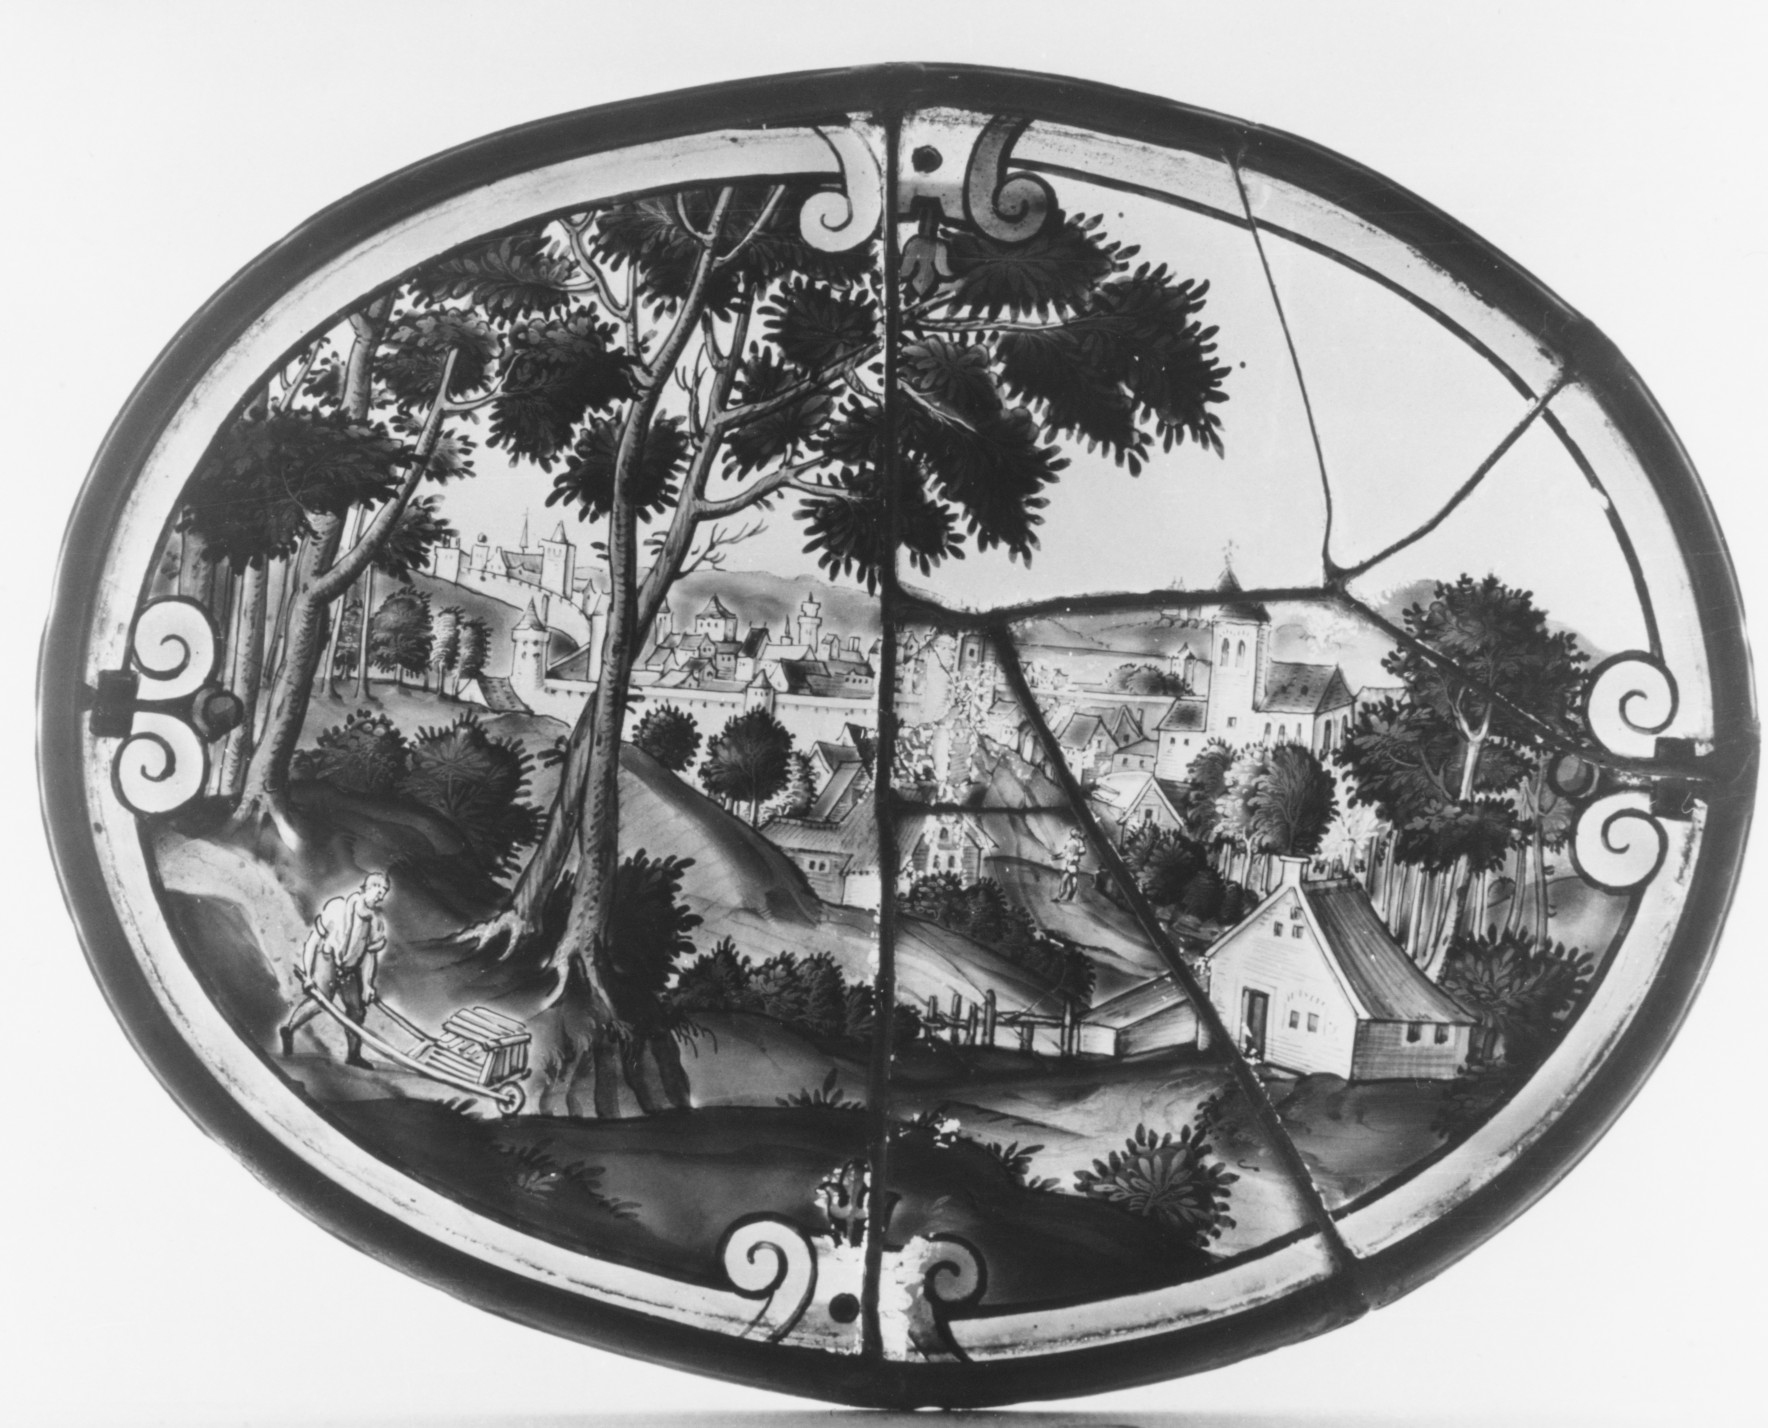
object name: panel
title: Landscape with view of a town (one of three)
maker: christoph murer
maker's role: maker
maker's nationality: swiss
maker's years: 1558-1614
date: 1601-1633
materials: glass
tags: buildings,towns,men,landscapes